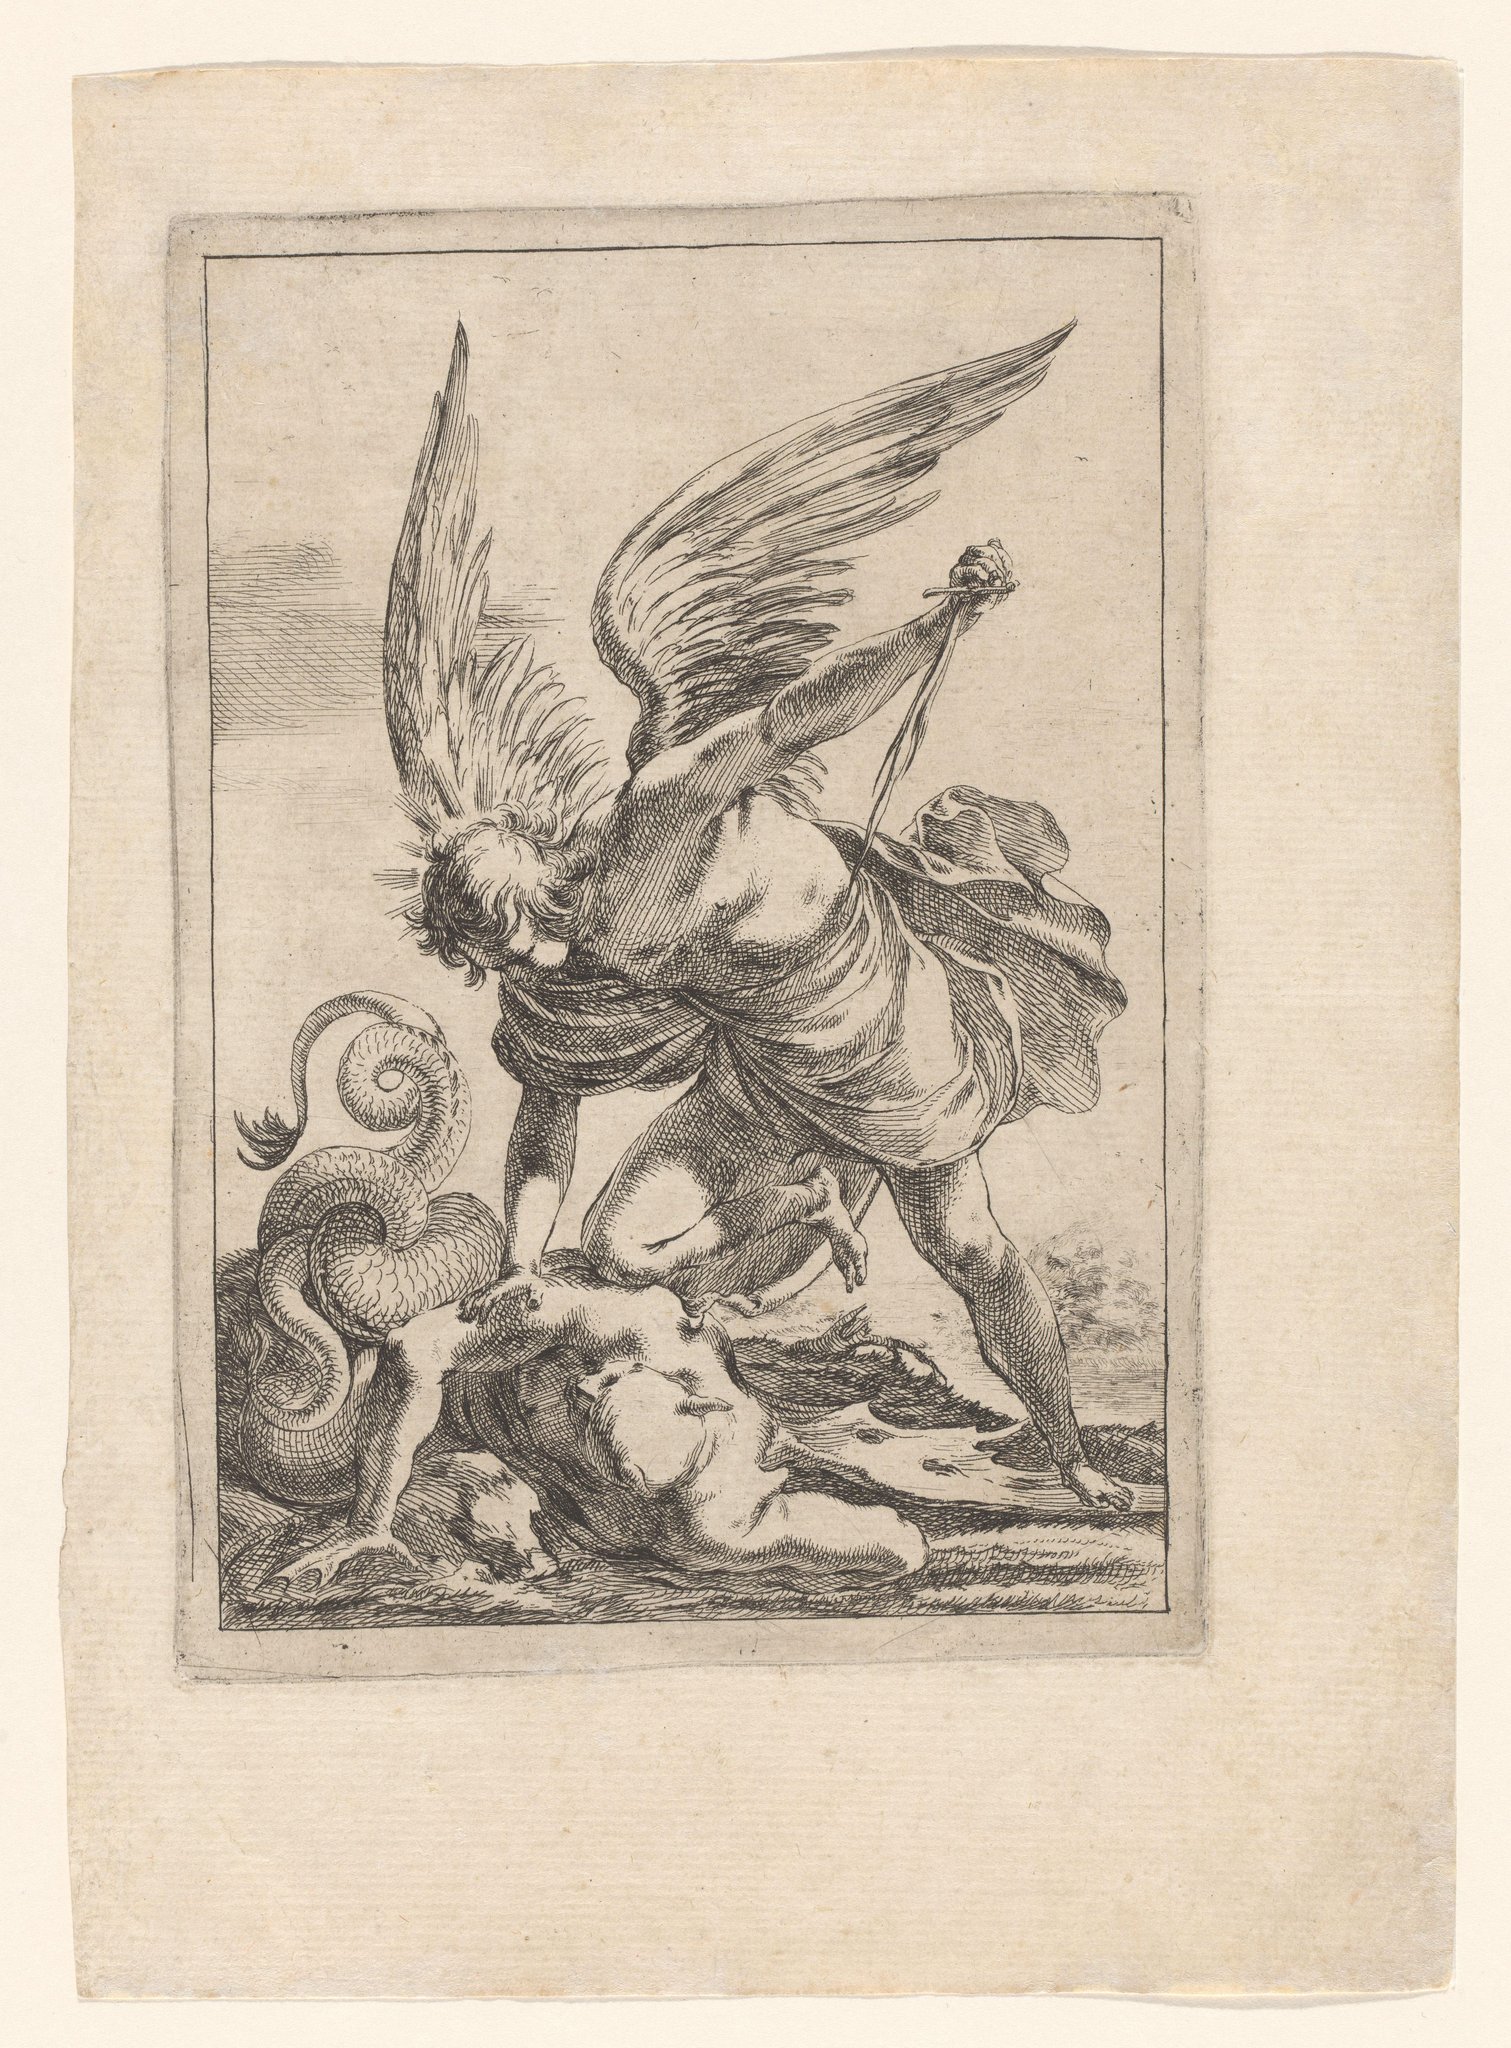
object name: print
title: Aartsengel Michael verslaat de draak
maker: laurent de la hire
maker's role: draughtsman, painter, print maker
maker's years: 1606-1656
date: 1630-1650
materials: paper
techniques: etching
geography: paris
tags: the archangel michael fighting the dragon (devil, satan)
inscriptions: collector's mark: Lugt 2760, collector's mark: Lugt 2228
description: Onbeschreven proefdruk voor de tekst. De prent ontbreekt in de catalogus van Robert-Dumesnil. Het enige andere bekende exemplaar betreft een afdruk met het signatuur van de maker en het adres en privilege van de uitgever Guérineau. Zie: Pierre Rosenberg, Jacques Thuillier, Laurent de la Hyre 1606-1656: L’homme et l’oeuvre, 1988, nr. 20. Onlangs is een schilderij ontdekt met hetzelfde onderwerp dat kan worden toegeschreven aan De la Hyre en dat waarschijnlijk als voorbeeld heeft gediend voor deze eigenhandige ets (Parijs (Sotheby’s), 26 juni 2014, lot 18).